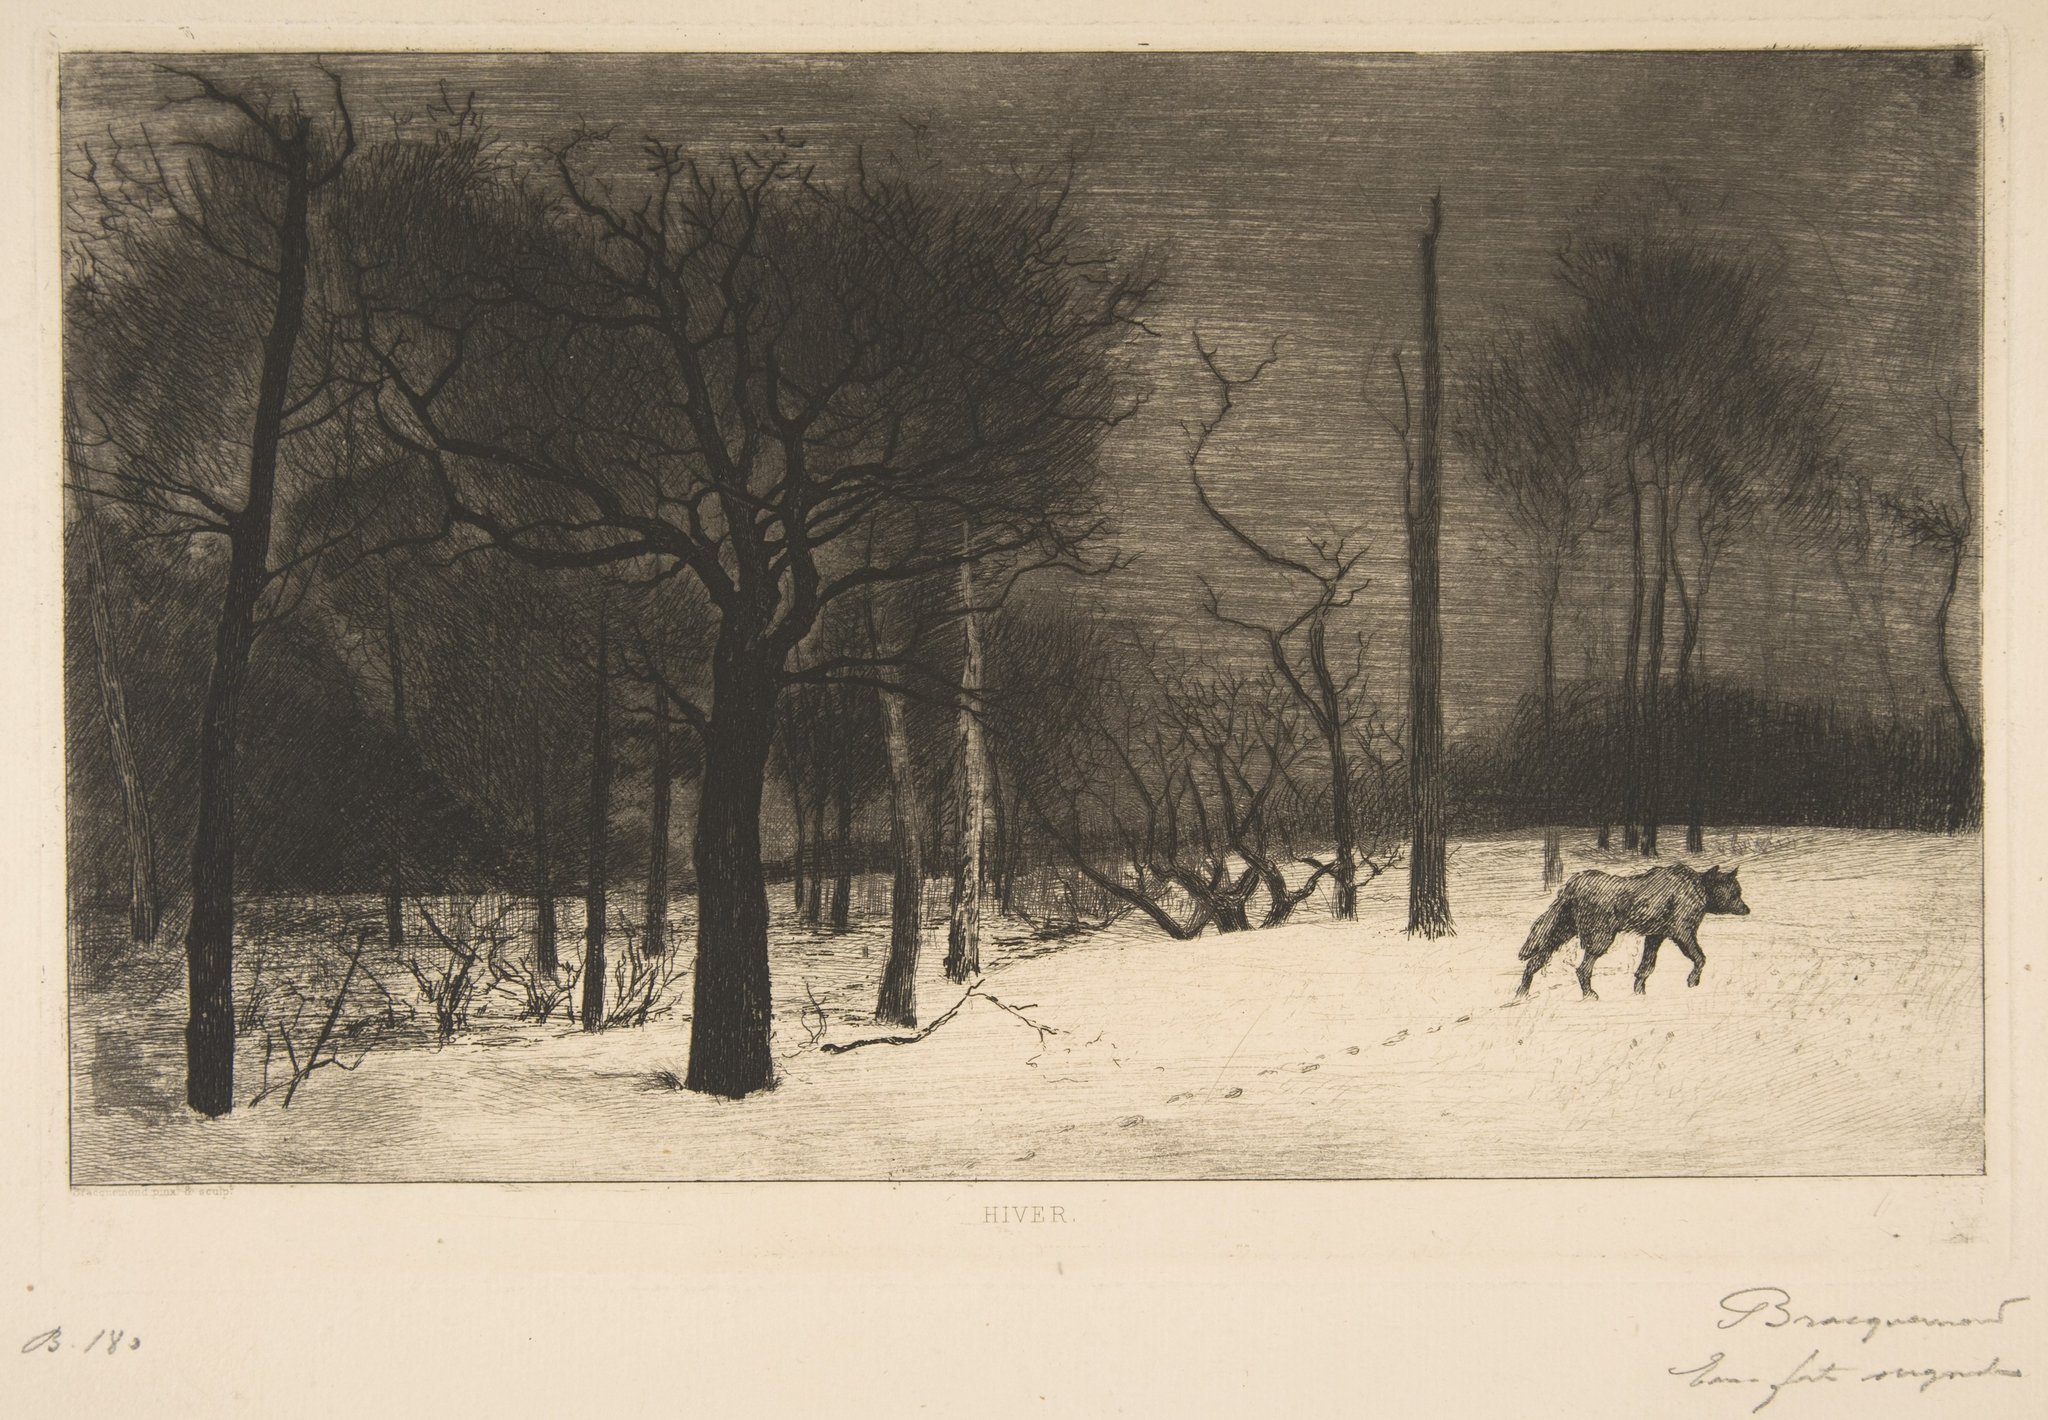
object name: print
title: Hiver (Le Loup dans la neige)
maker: félix bracquemond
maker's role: artist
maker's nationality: french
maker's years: 1833-1914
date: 1864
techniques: etching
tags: animals,trees,snow